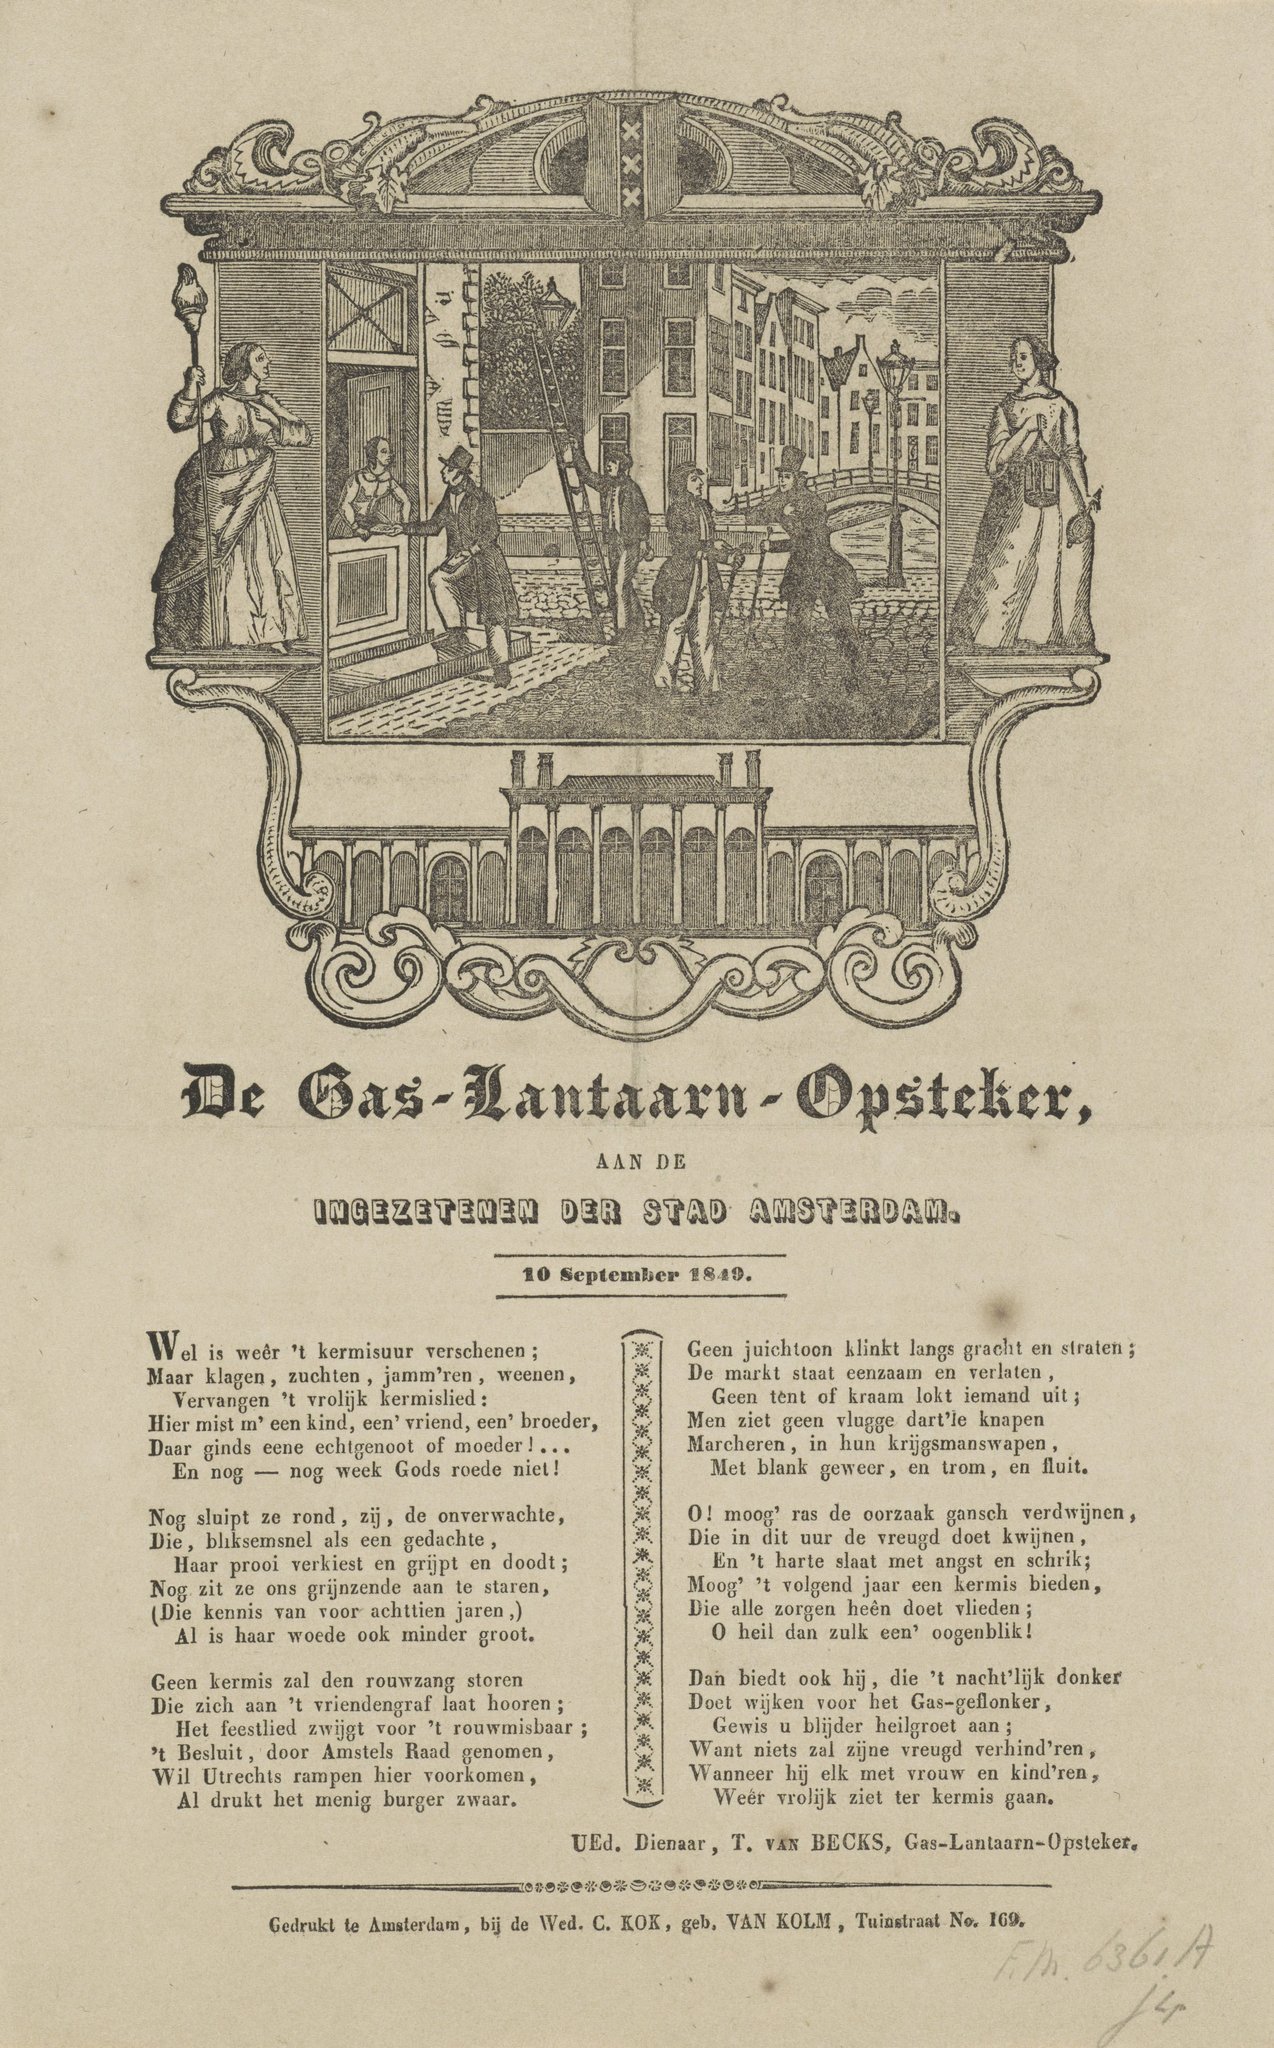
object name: print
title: Kermisprent van de gaslantaarnopstekers van Amsterdam voor het jaar 1849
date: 1849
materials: paper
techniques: letterpress printing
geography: amsterdam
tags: gas-lamp (+ kindling a light; lit, burning light, lamp, candle), street lighting, street, amsterdam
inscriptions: collector's mark: Lugt 2228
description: Kermisprent van de Amsterdamse gaslantaarnopstekers, 10 september 1849. Cartouche met een gezicht in een straat in Amsterdam waar enkele mannen bezig zijn de straatlantaarns aan te steken. Een andere man haalt geld op bij een huis. Links en rechts een staande vrouw met een fakkel en een olielantaarn, onderaan de Amsterdamse gasfabriek. Van de gaslantaarnopsteker: T. van Becks.